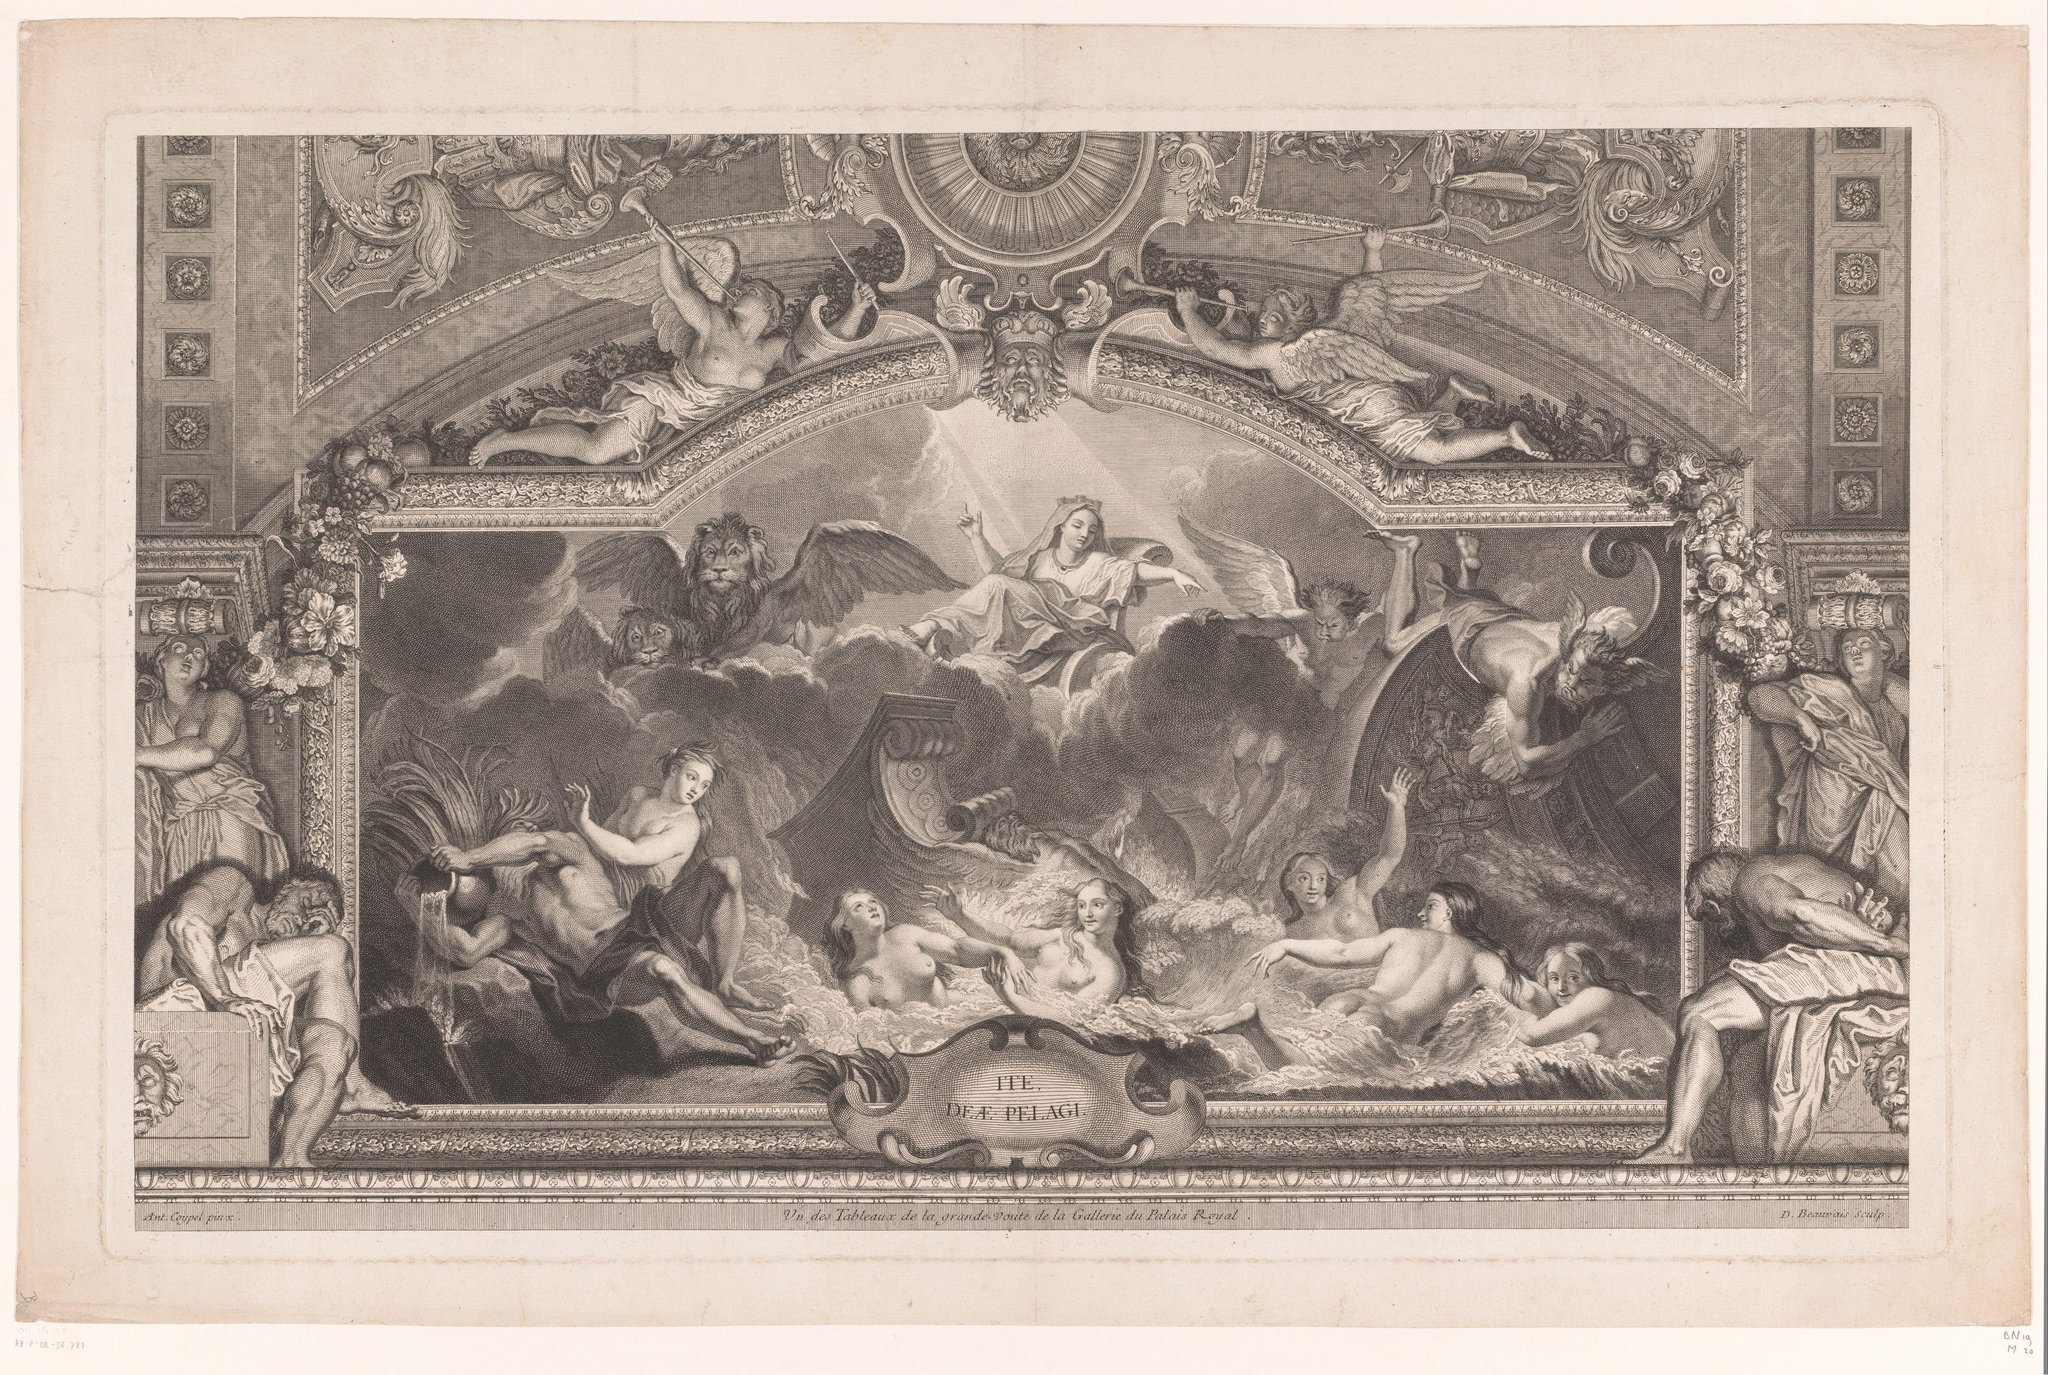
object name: print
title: Ite deae pelagi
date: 1697-1763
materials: paper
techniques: engraving, etching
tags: when turnus sets the trojan ships on fire they turn into sea-nymphs at cybele's request, (decorated) ceiling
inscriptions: collector's mark: Lugt 240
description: Dit is een prent naar een plafondschildering in het Koninklijk Paleis.